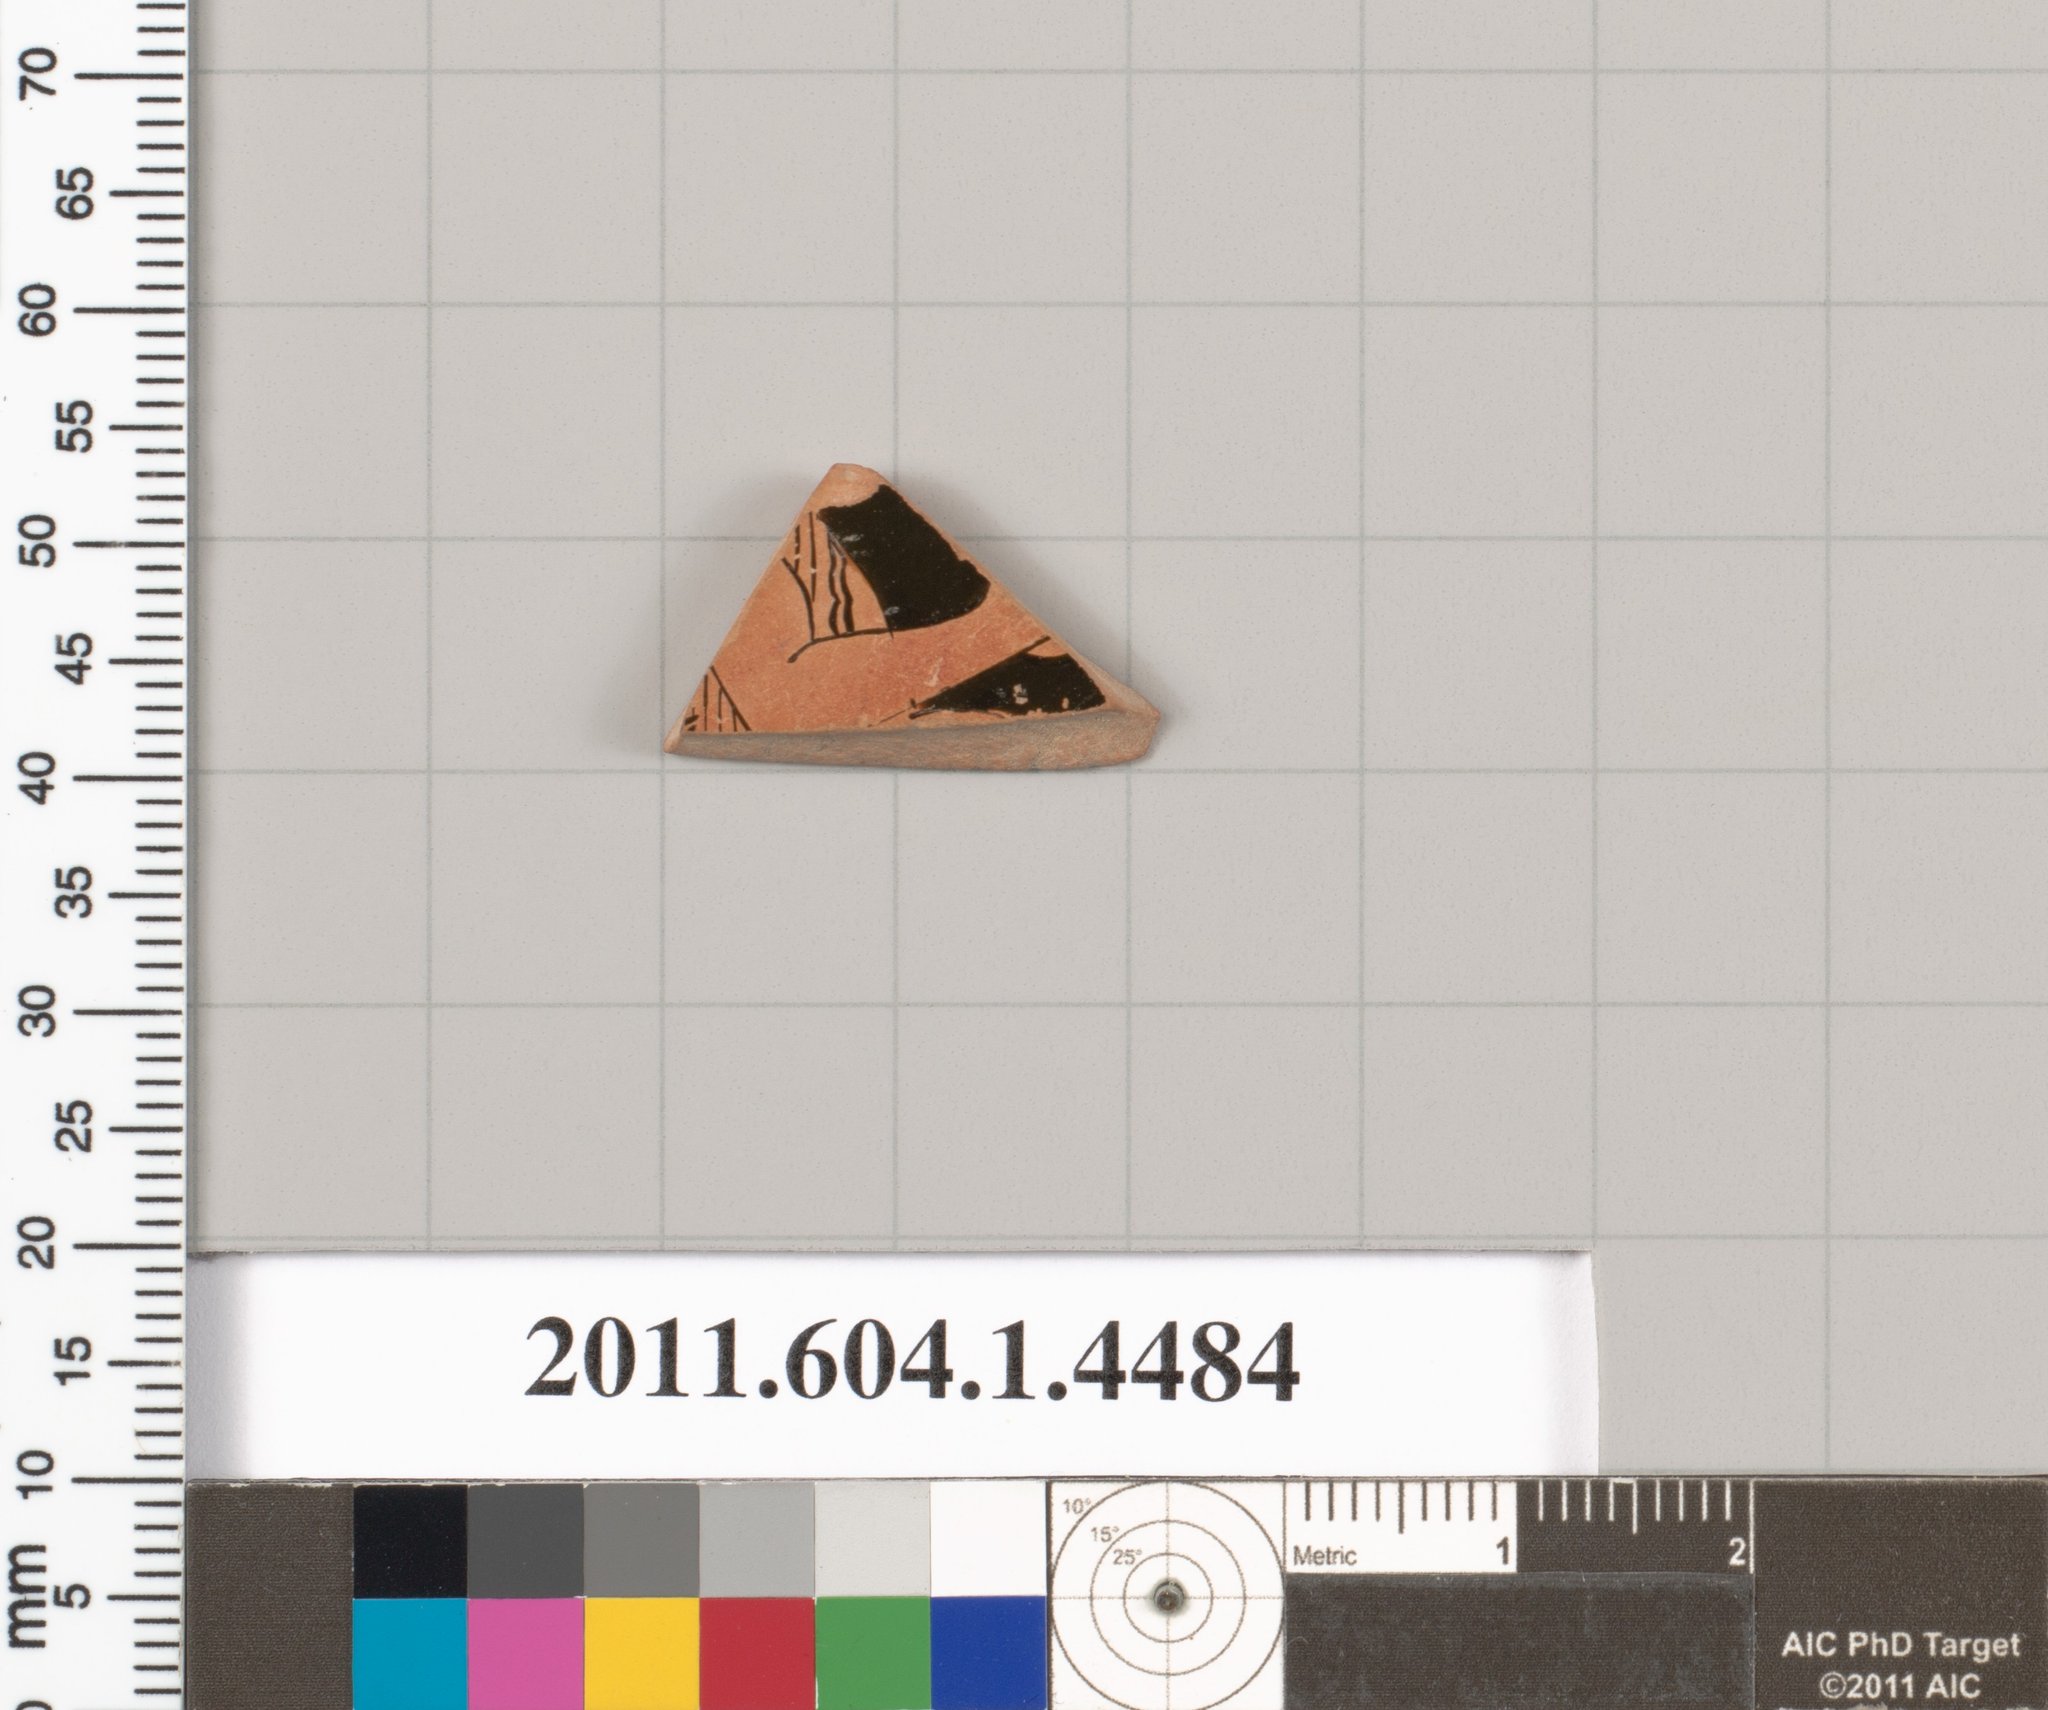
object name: kylix fragment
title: Terracotta fragment of a kylix (drinking cup)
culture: greek, attic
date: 490-480 BCE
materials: terracotta